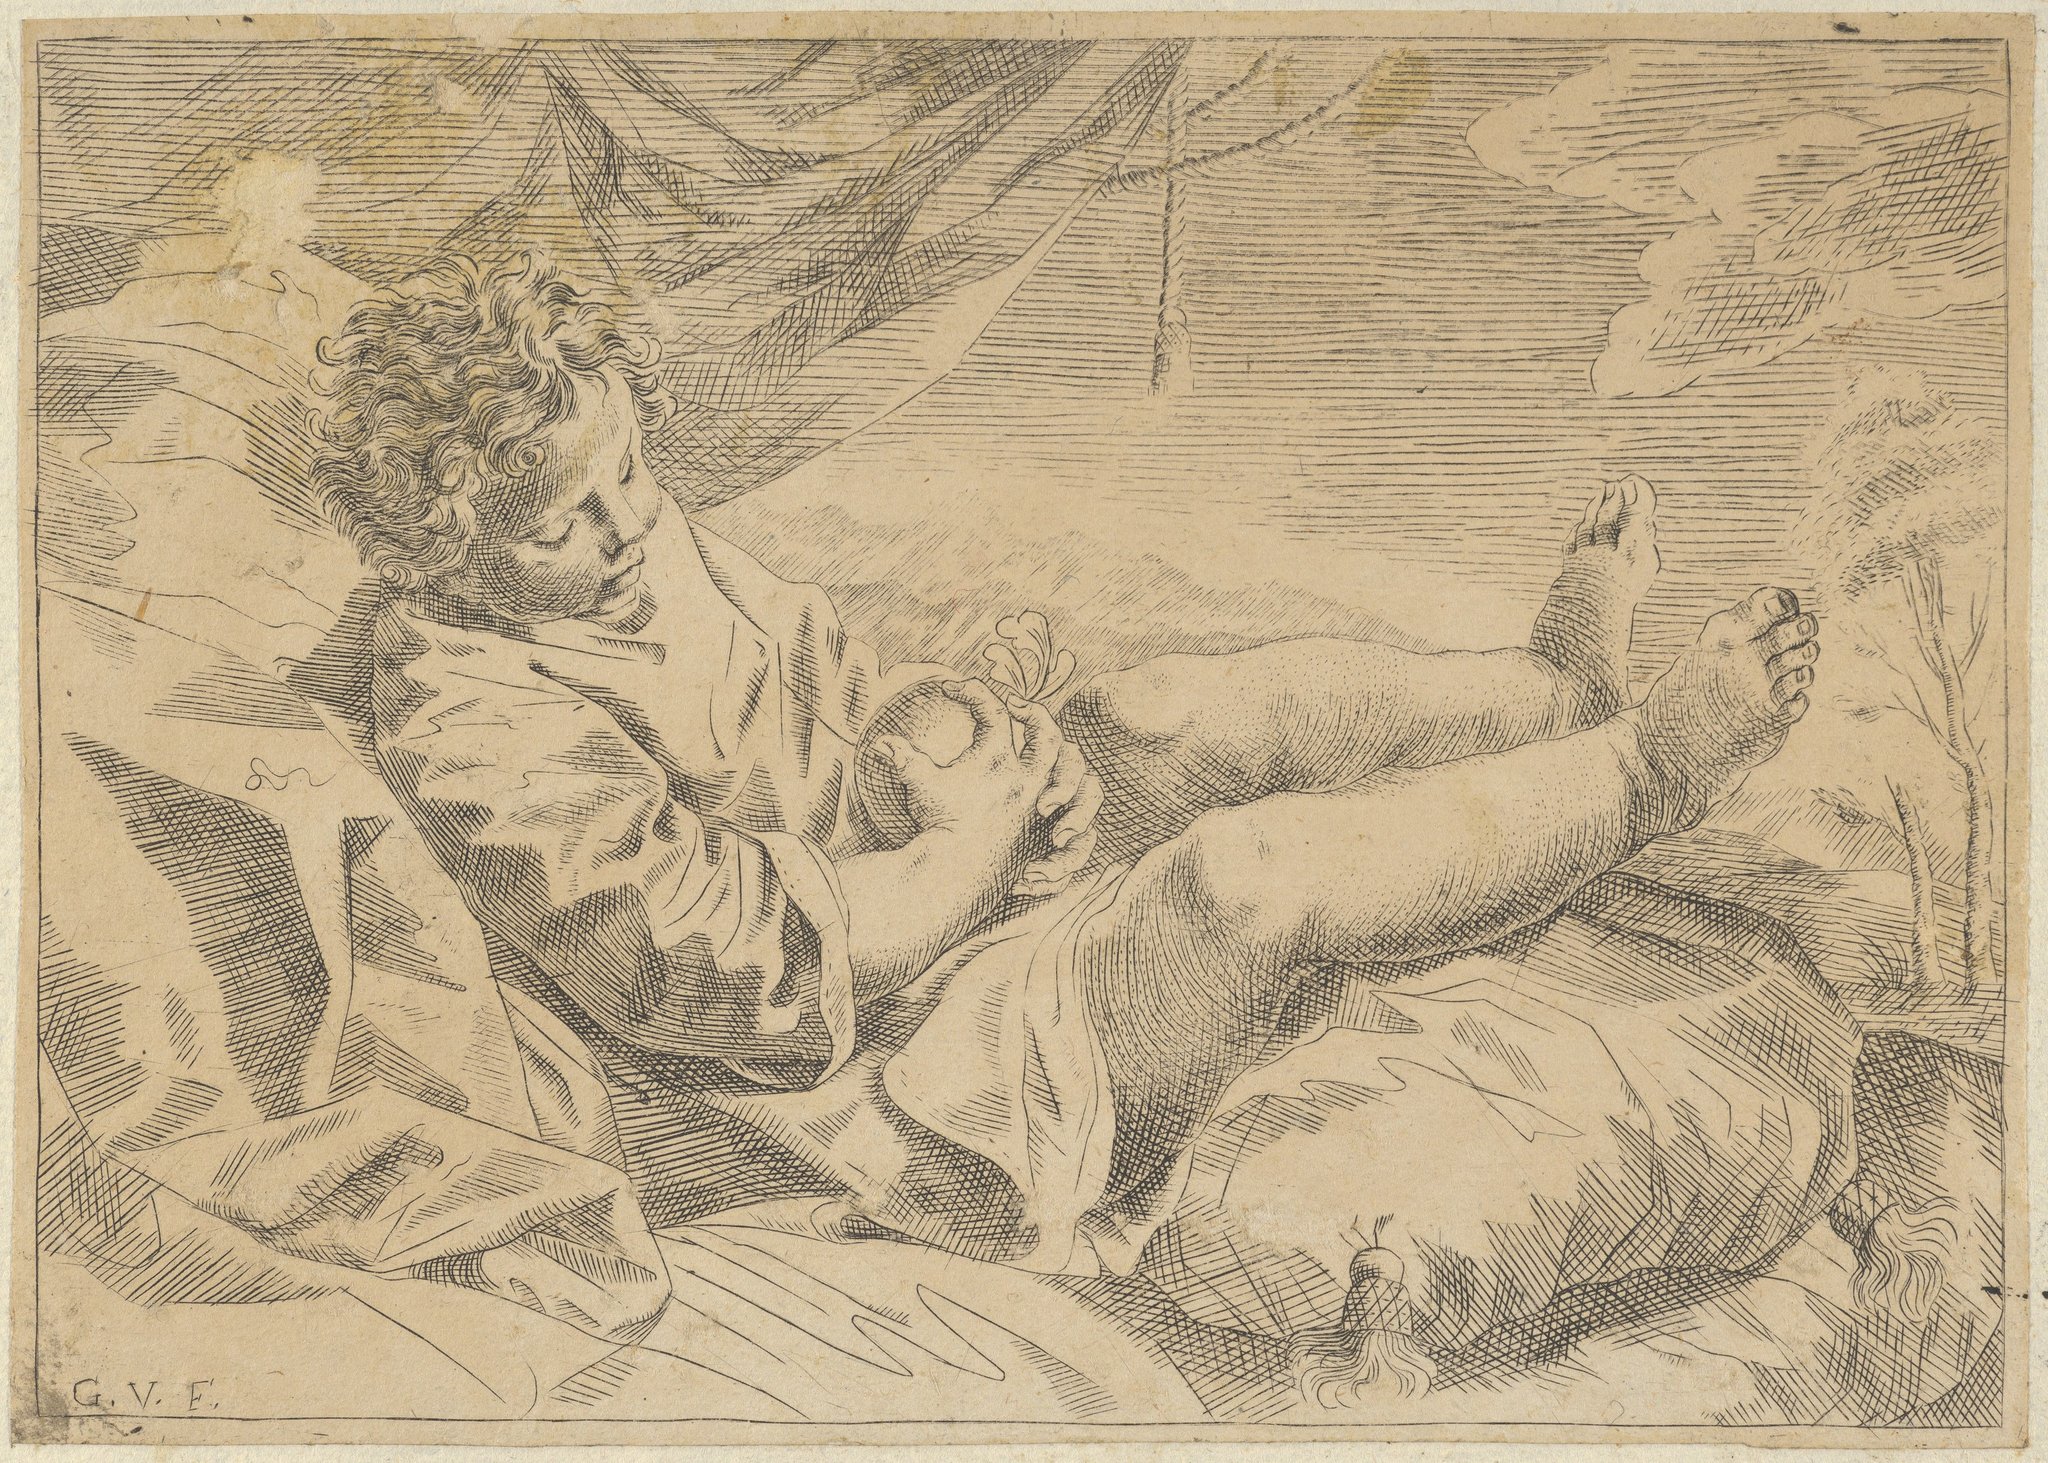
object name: print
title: A child sleeping on a cushion, holding a piece of fruit (?), a curtain behind him, after Reni (?)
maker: anonymous, 17th century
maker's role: artist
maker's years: 1600-1700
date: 1601-1700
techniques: engraving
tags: sleeping,children